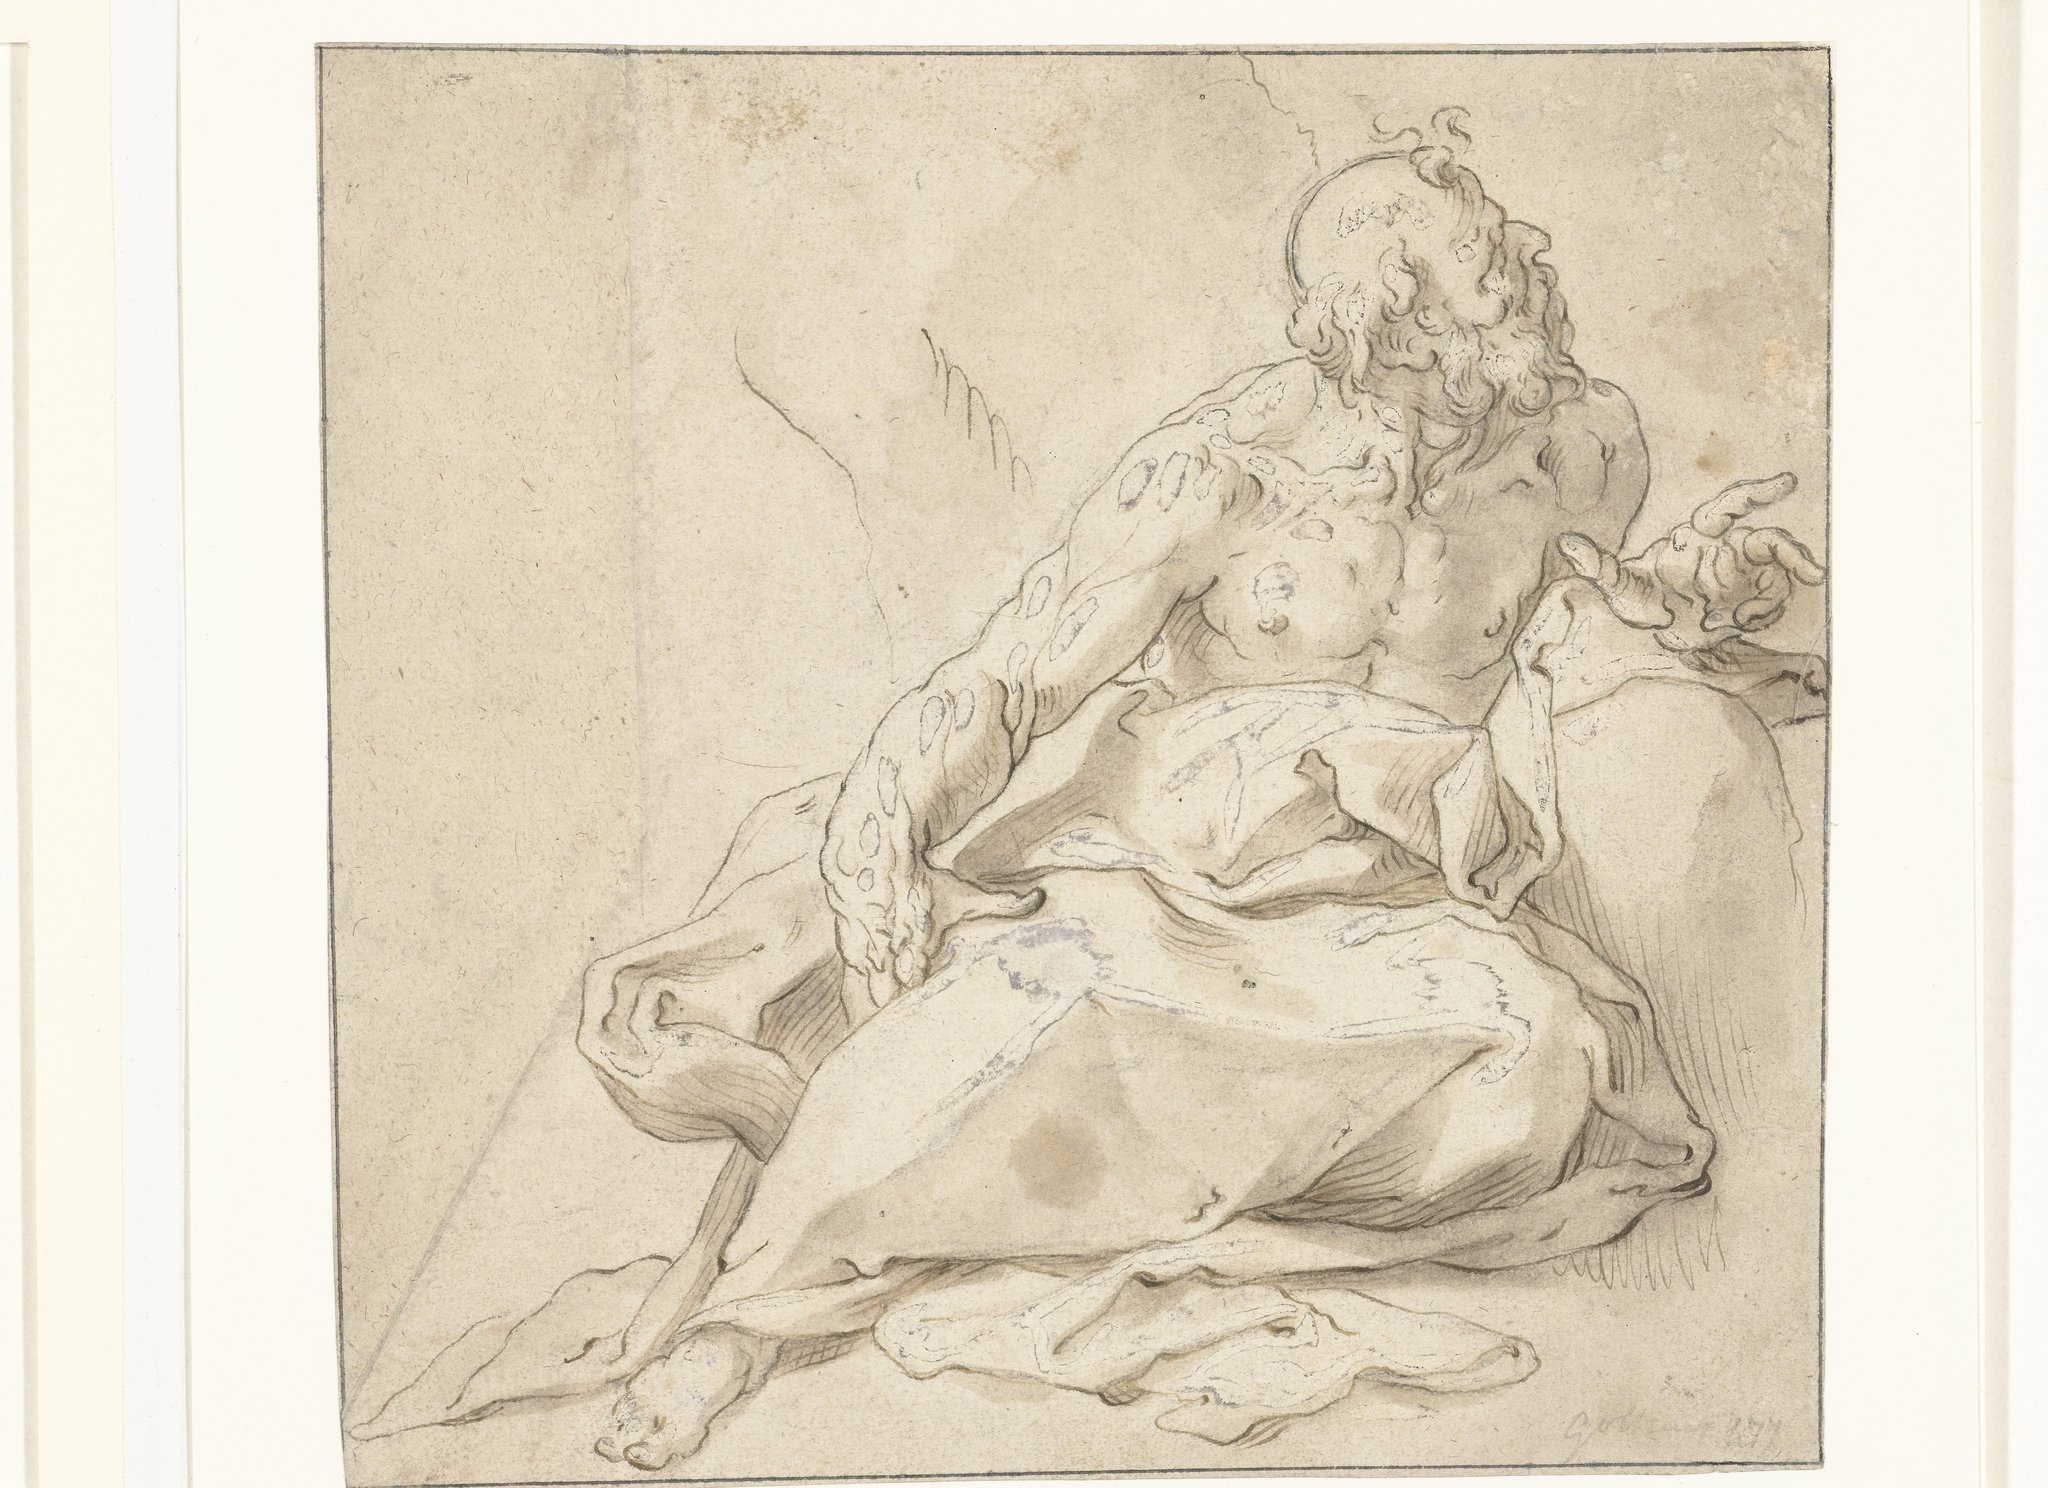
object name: drawing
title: Heilige Hieronymus in de woestijn (?)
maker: abraham bloemaert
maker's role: draughtsman, painter, print maker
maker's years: 1566-1651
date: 1574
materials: paper, chalk, ink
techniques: brush, pen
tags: the monk and hermit jerome (hieronymus); possible attributes: book, cardinal's hat, crucifix, hour-glass, lion, skull, stone